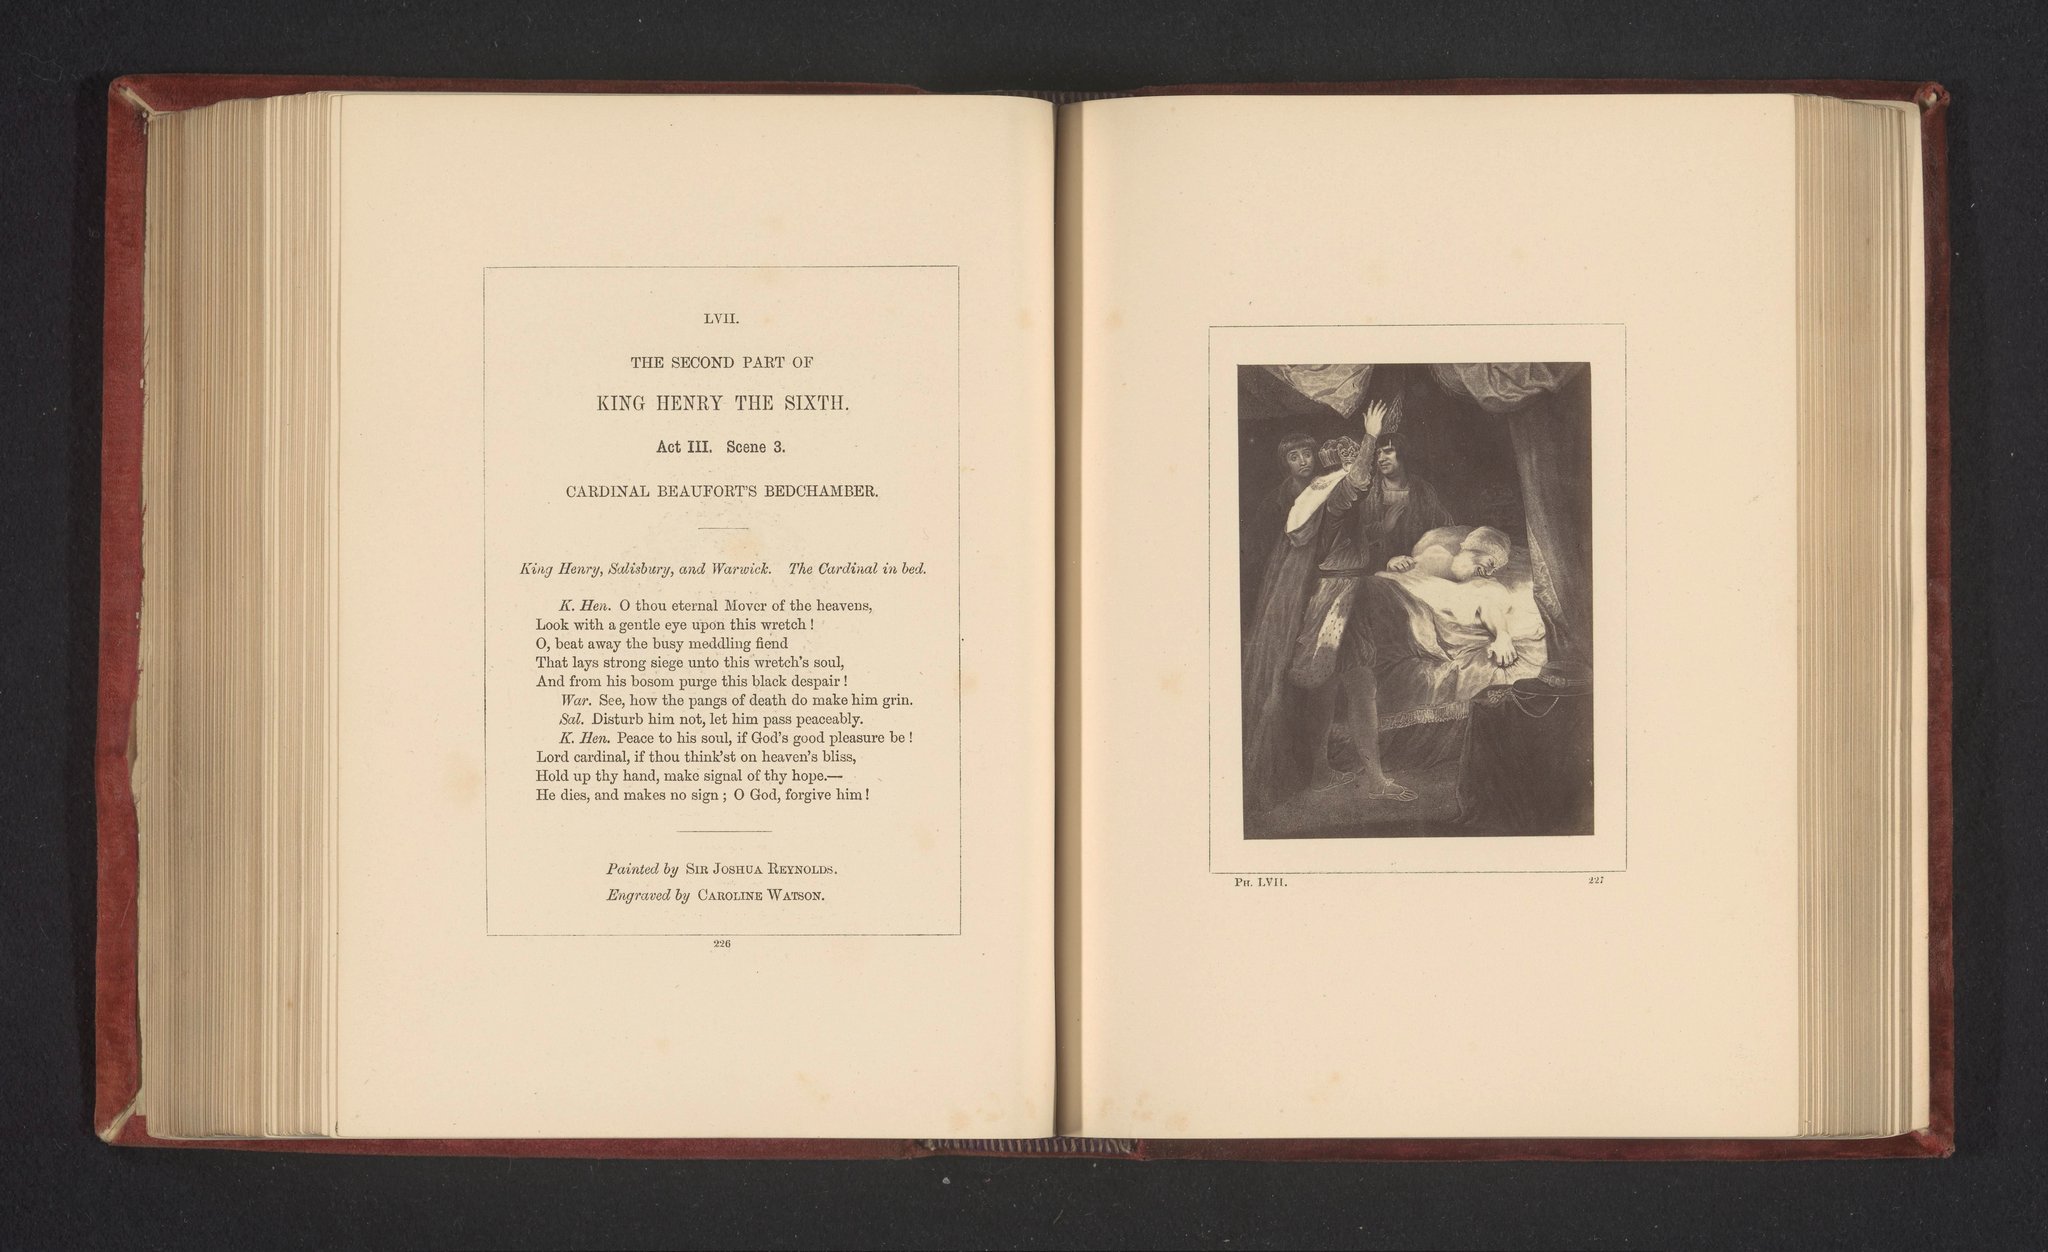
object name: photograph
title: Fotoreproductie van een prent naar een schilderij door Joshua Reynolds, voorstellend een scene uit Hendrik VI, deel 2 door William Shakespeare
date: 1854-1864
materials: photographic support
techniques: albumen print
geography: london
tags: london, specific works of literature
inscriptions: number: ‘Ph. LVII. 227’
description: Te zien is akte III, scene 3 met de kardinaal in bed en koning Henry VI, de graaf van Salisbury en de graaf van Warwick ervoor.